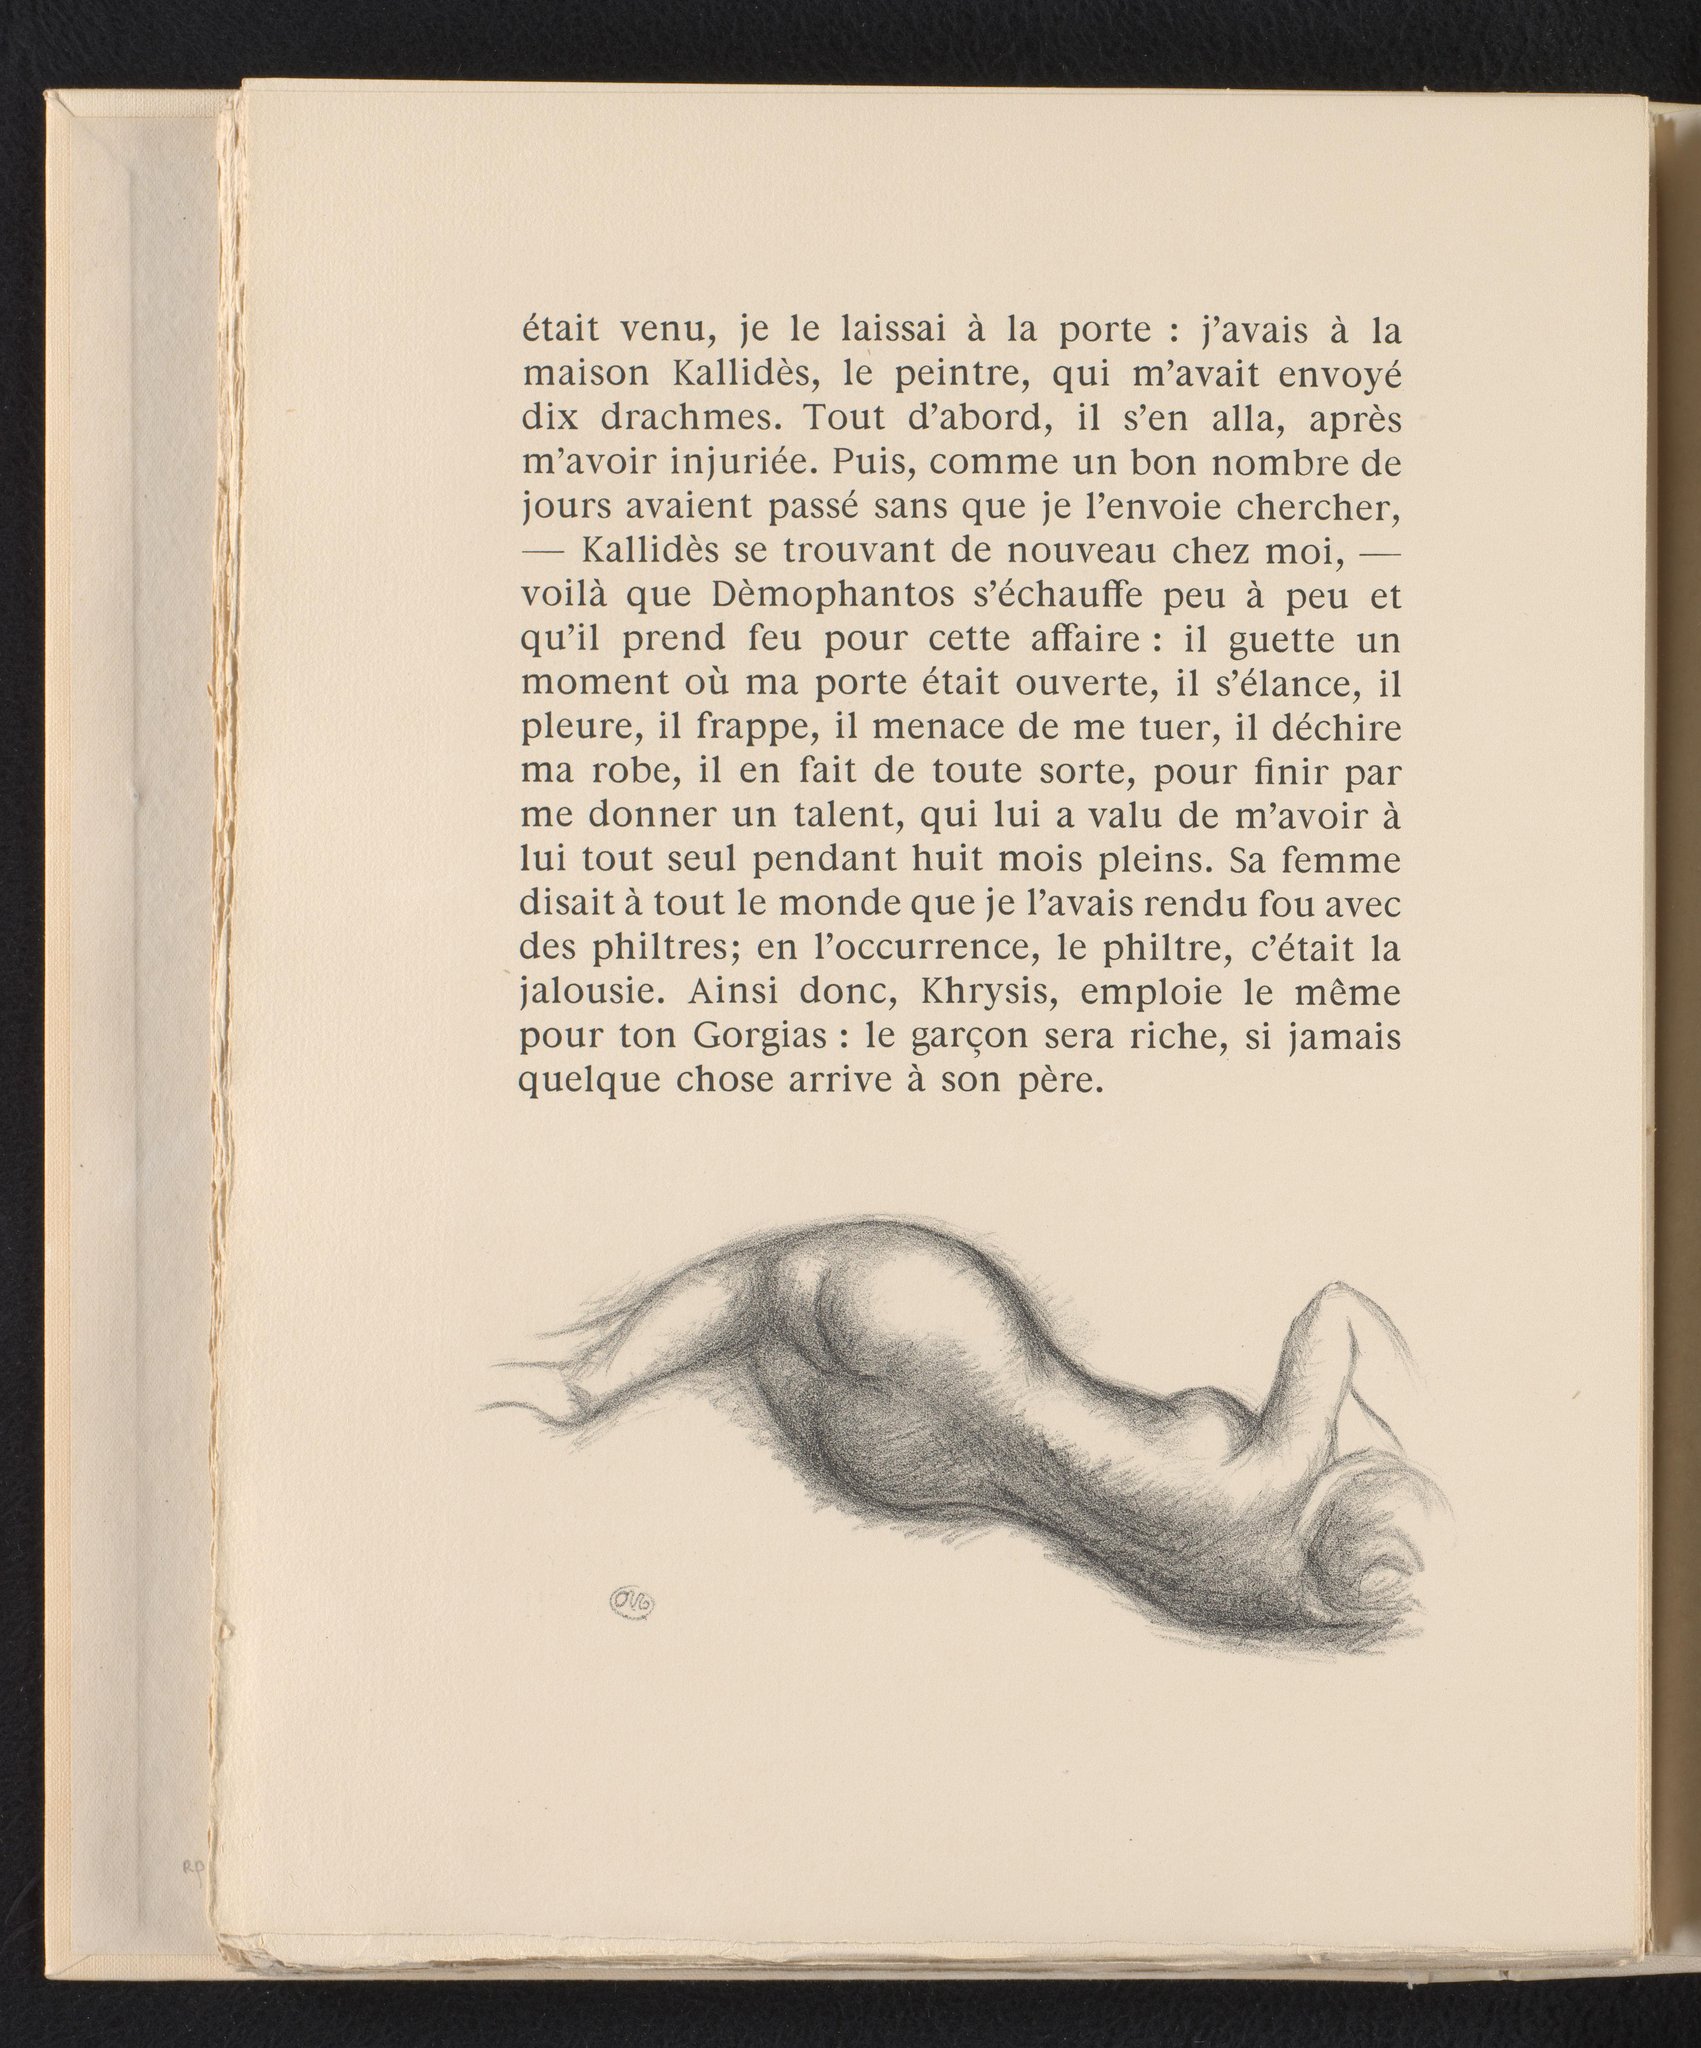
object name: print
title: Op haar rechterzij liggende naakte vrouw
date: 1948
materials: paper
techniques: letterpress printing, lithograph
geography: paris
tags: lying on one side, stretched out - aa - female human figure, woman (showing herself) undressed, quasi-nude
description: Prent uit: Lucianus van Samosata. Dialogues des Courtisanes. [Vertaald uit het Grieks door] Charles Astruc. Parijs: s.n., 1948, p. 46.